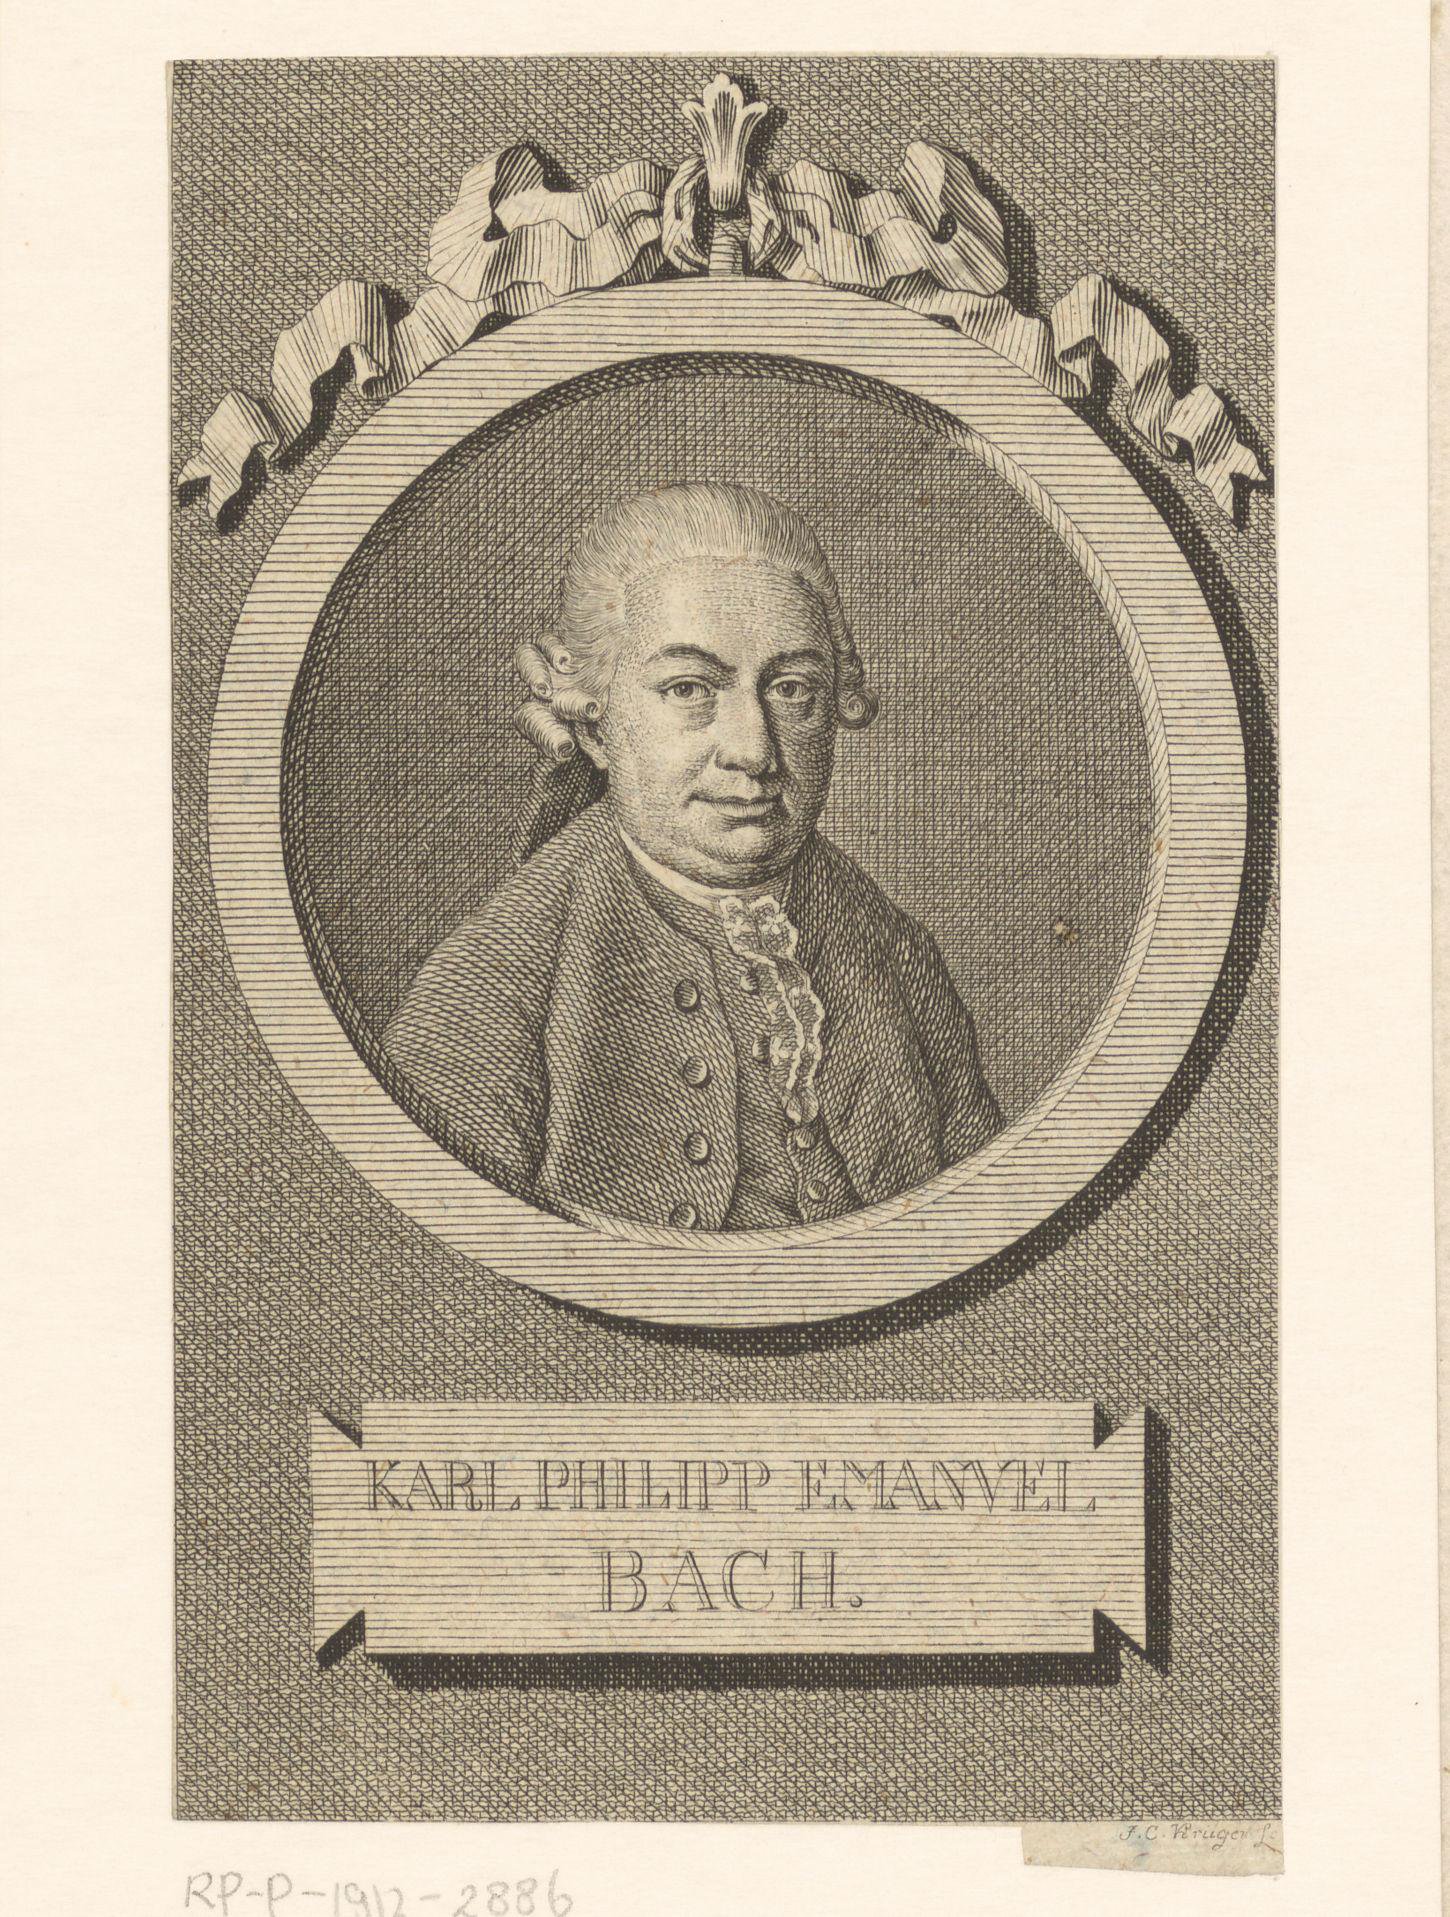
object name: print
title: Portret van Carl Philipp Emanuel Bach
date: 1778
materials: paper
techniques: engraving, etching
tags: historical persons, portrait of composer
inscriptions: collector's mark: Lugt 2228